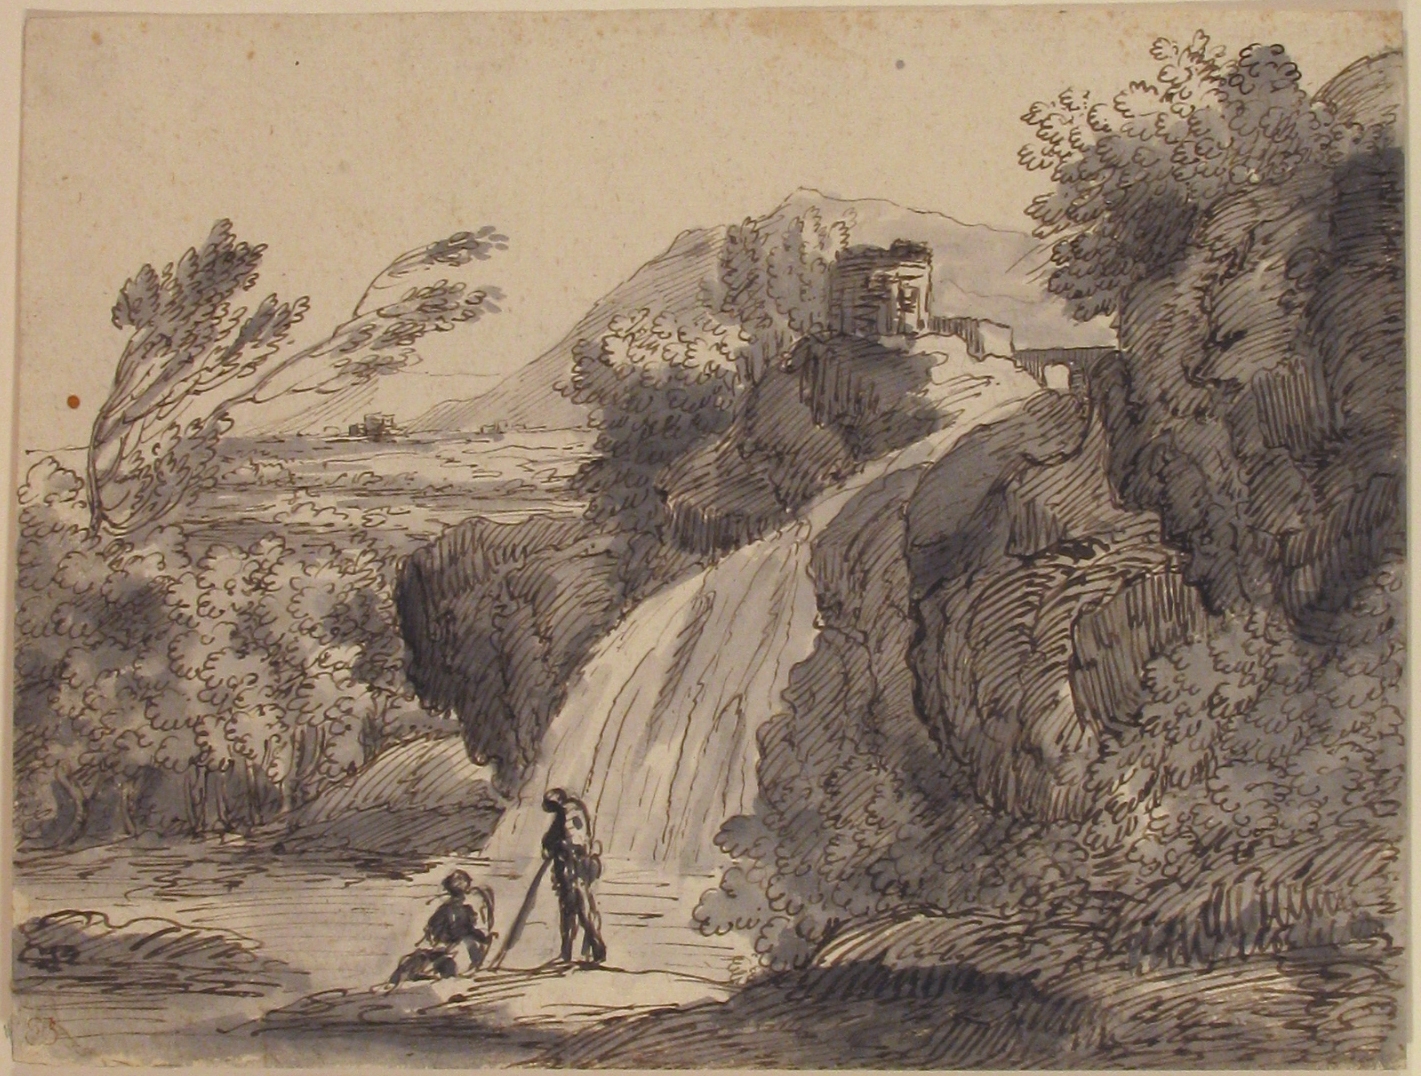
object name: drawing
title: A Harbor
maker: anonymous, french, 17th century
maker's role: artist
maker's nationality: french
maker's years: 1600-1700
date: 1601-1700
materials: ink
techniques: brush, pen, wash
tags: mountains,landscapes